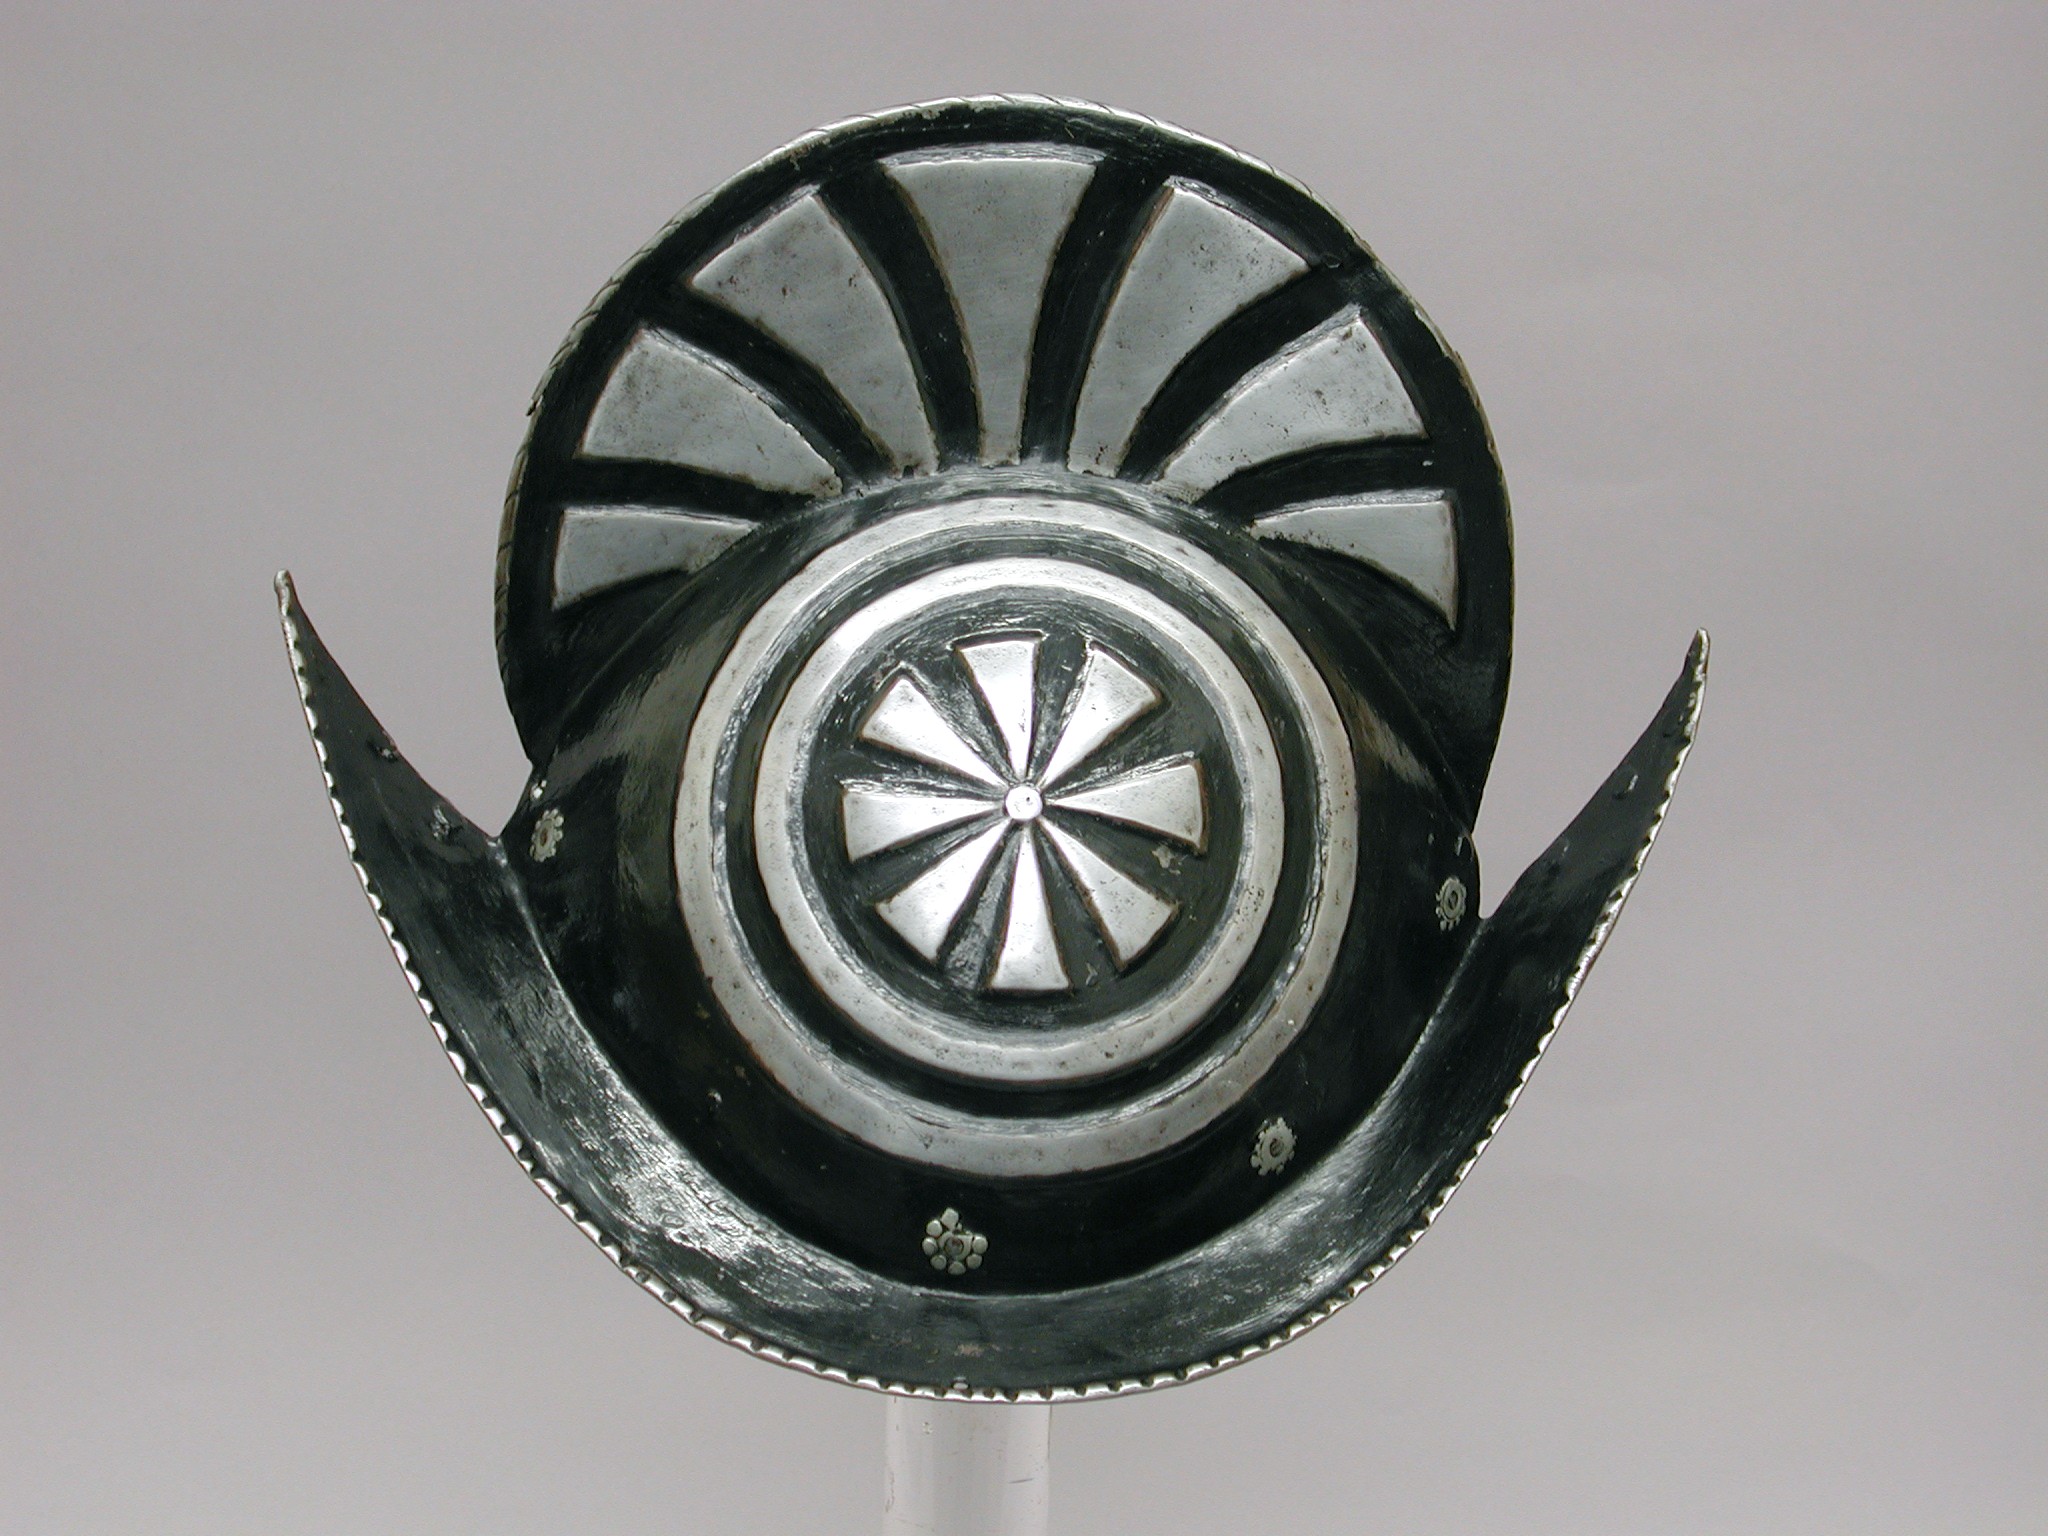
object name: morion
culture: german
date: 1600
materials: pigment, steel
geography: germany